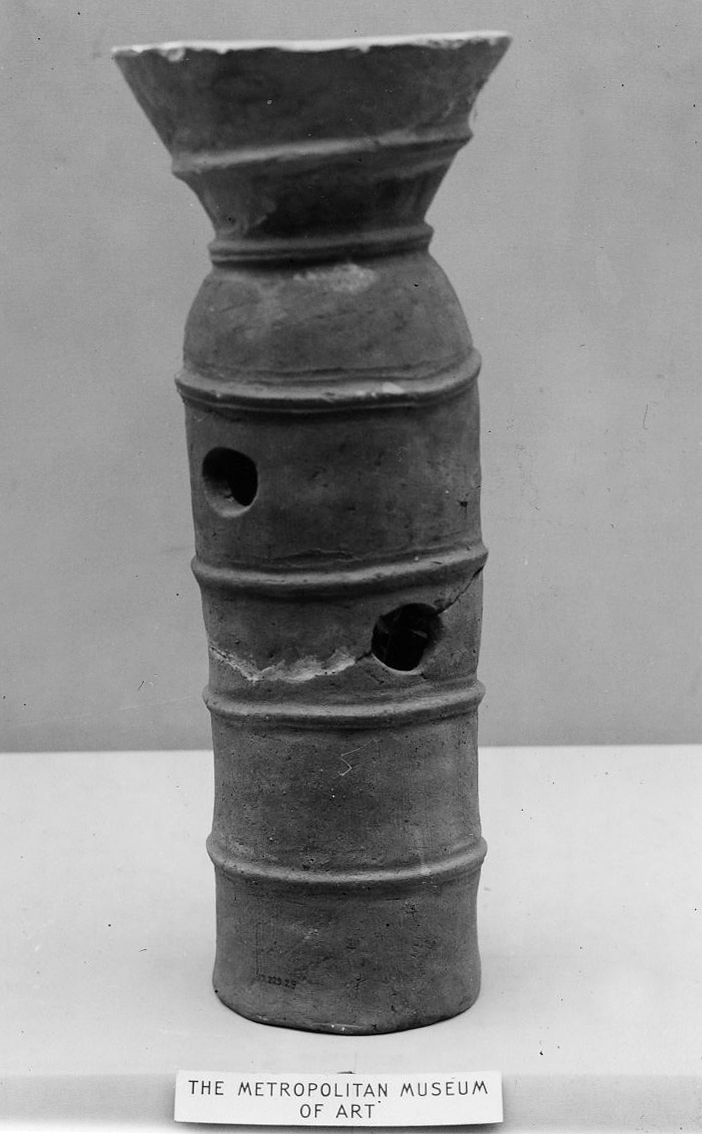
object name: haniwa base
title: Haniwa Base of a Figure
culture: japanese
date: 201-600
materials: pottery